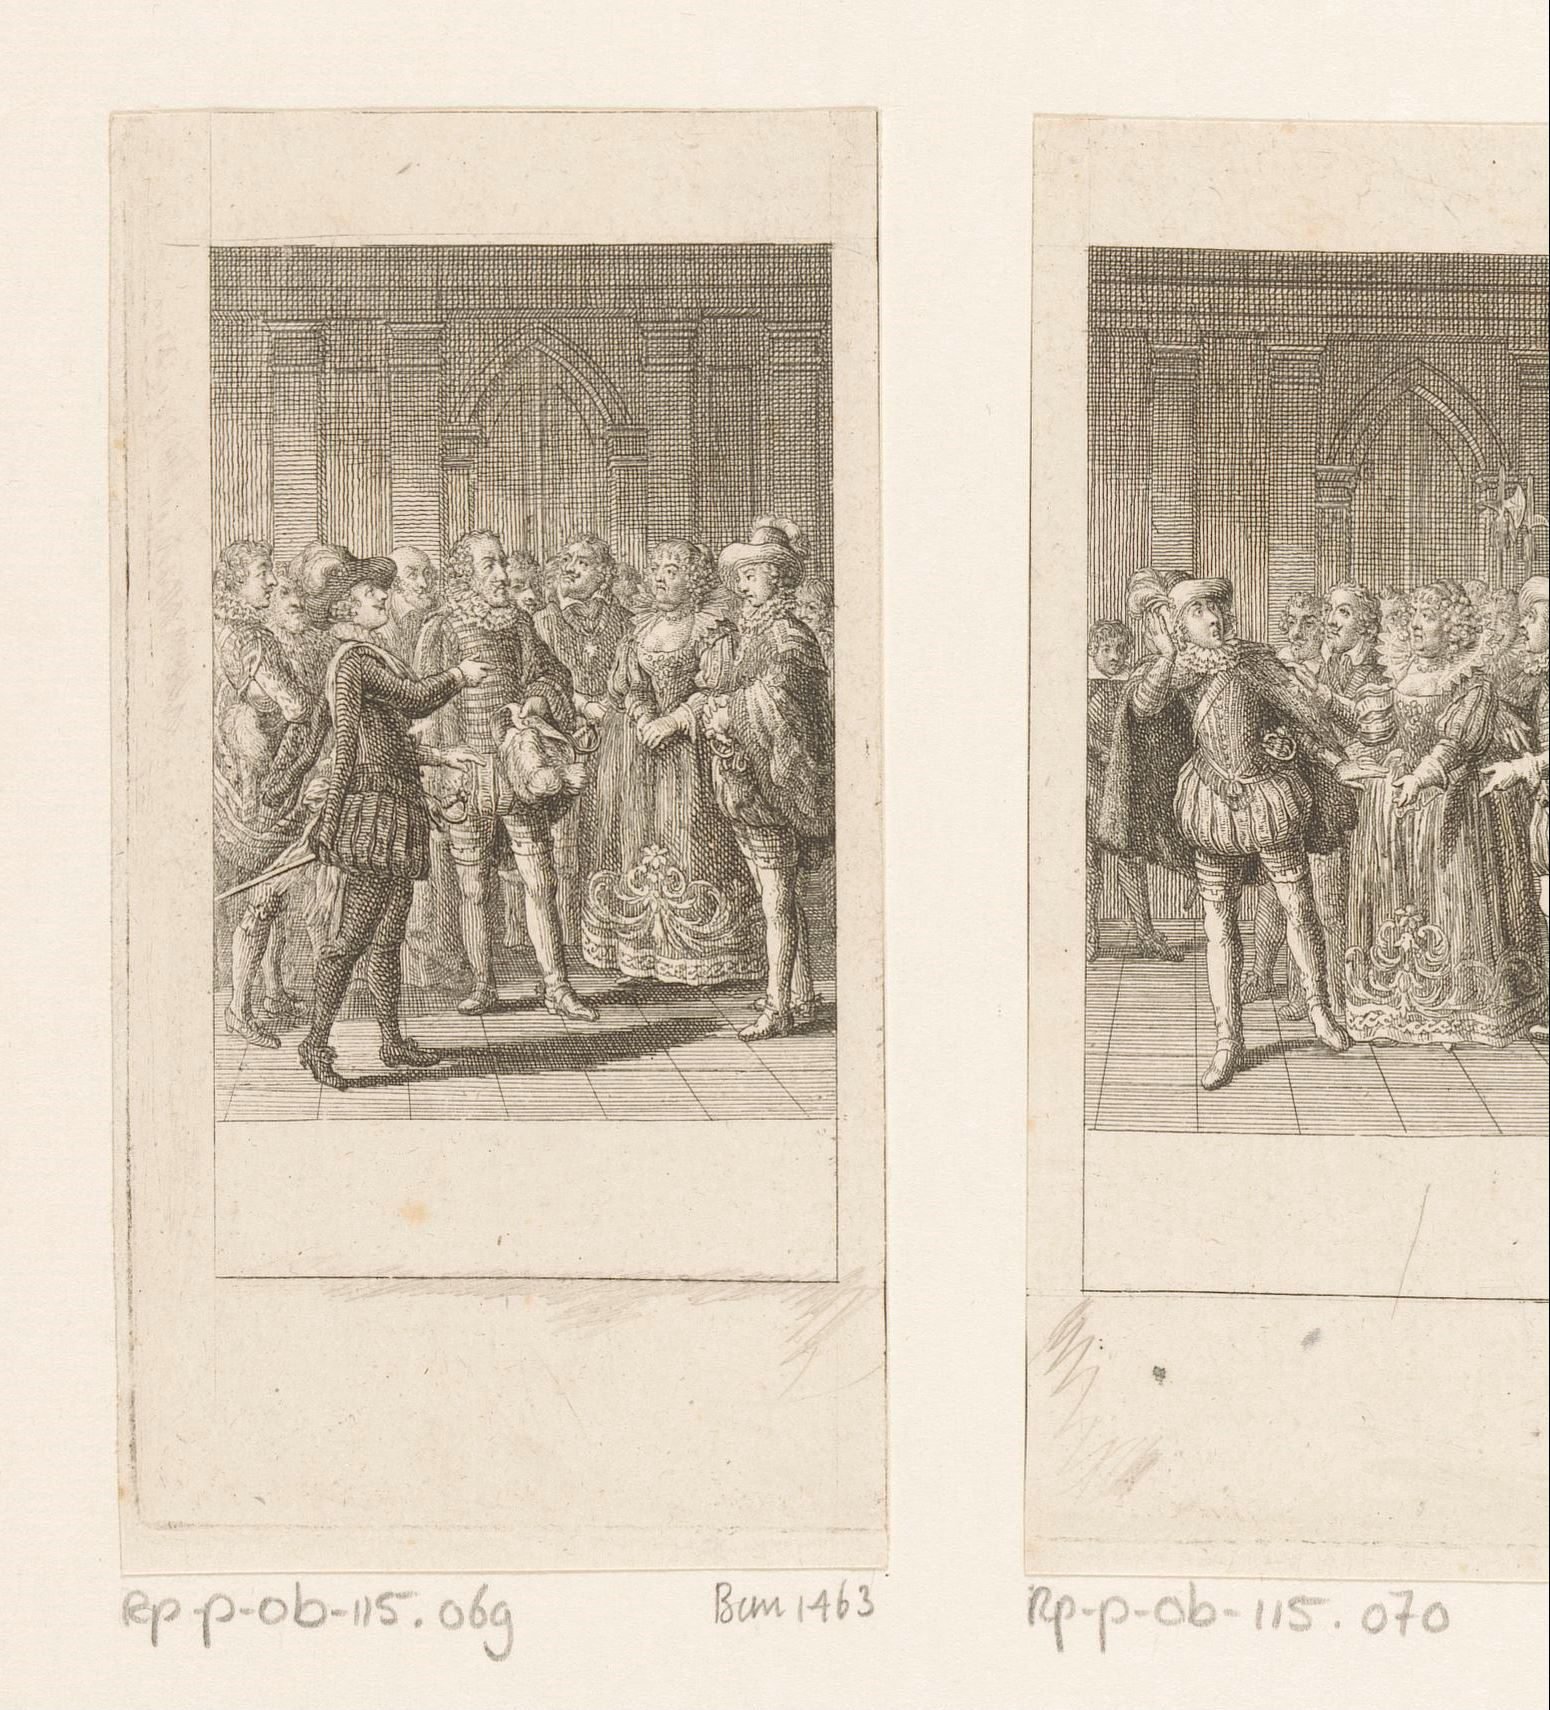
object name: print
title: Hendrik van Navarra tegenover Karel IX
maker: daniel nikolaus chodowiecki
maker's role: draughtsman, print maker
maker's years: 1726-1801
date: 1790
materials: paper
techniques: etching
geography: berlin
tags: karel ix (koning van frankrijk), politician, gaspard de coligny (ii), paris, hendrik iv (koning van frankrijk en navarra), enemy, meeting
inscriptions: collector's mark: Lugt 2228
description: Vervaardigd voor 'Charles IX' van Marie-Joseph Chénier. Latere staat gebruikt voor: Goettinger Taschen Calender für 1791. bey Joh. Chr. Dietrich. Göttingen: Johann Christoph Dietrich, [1790].